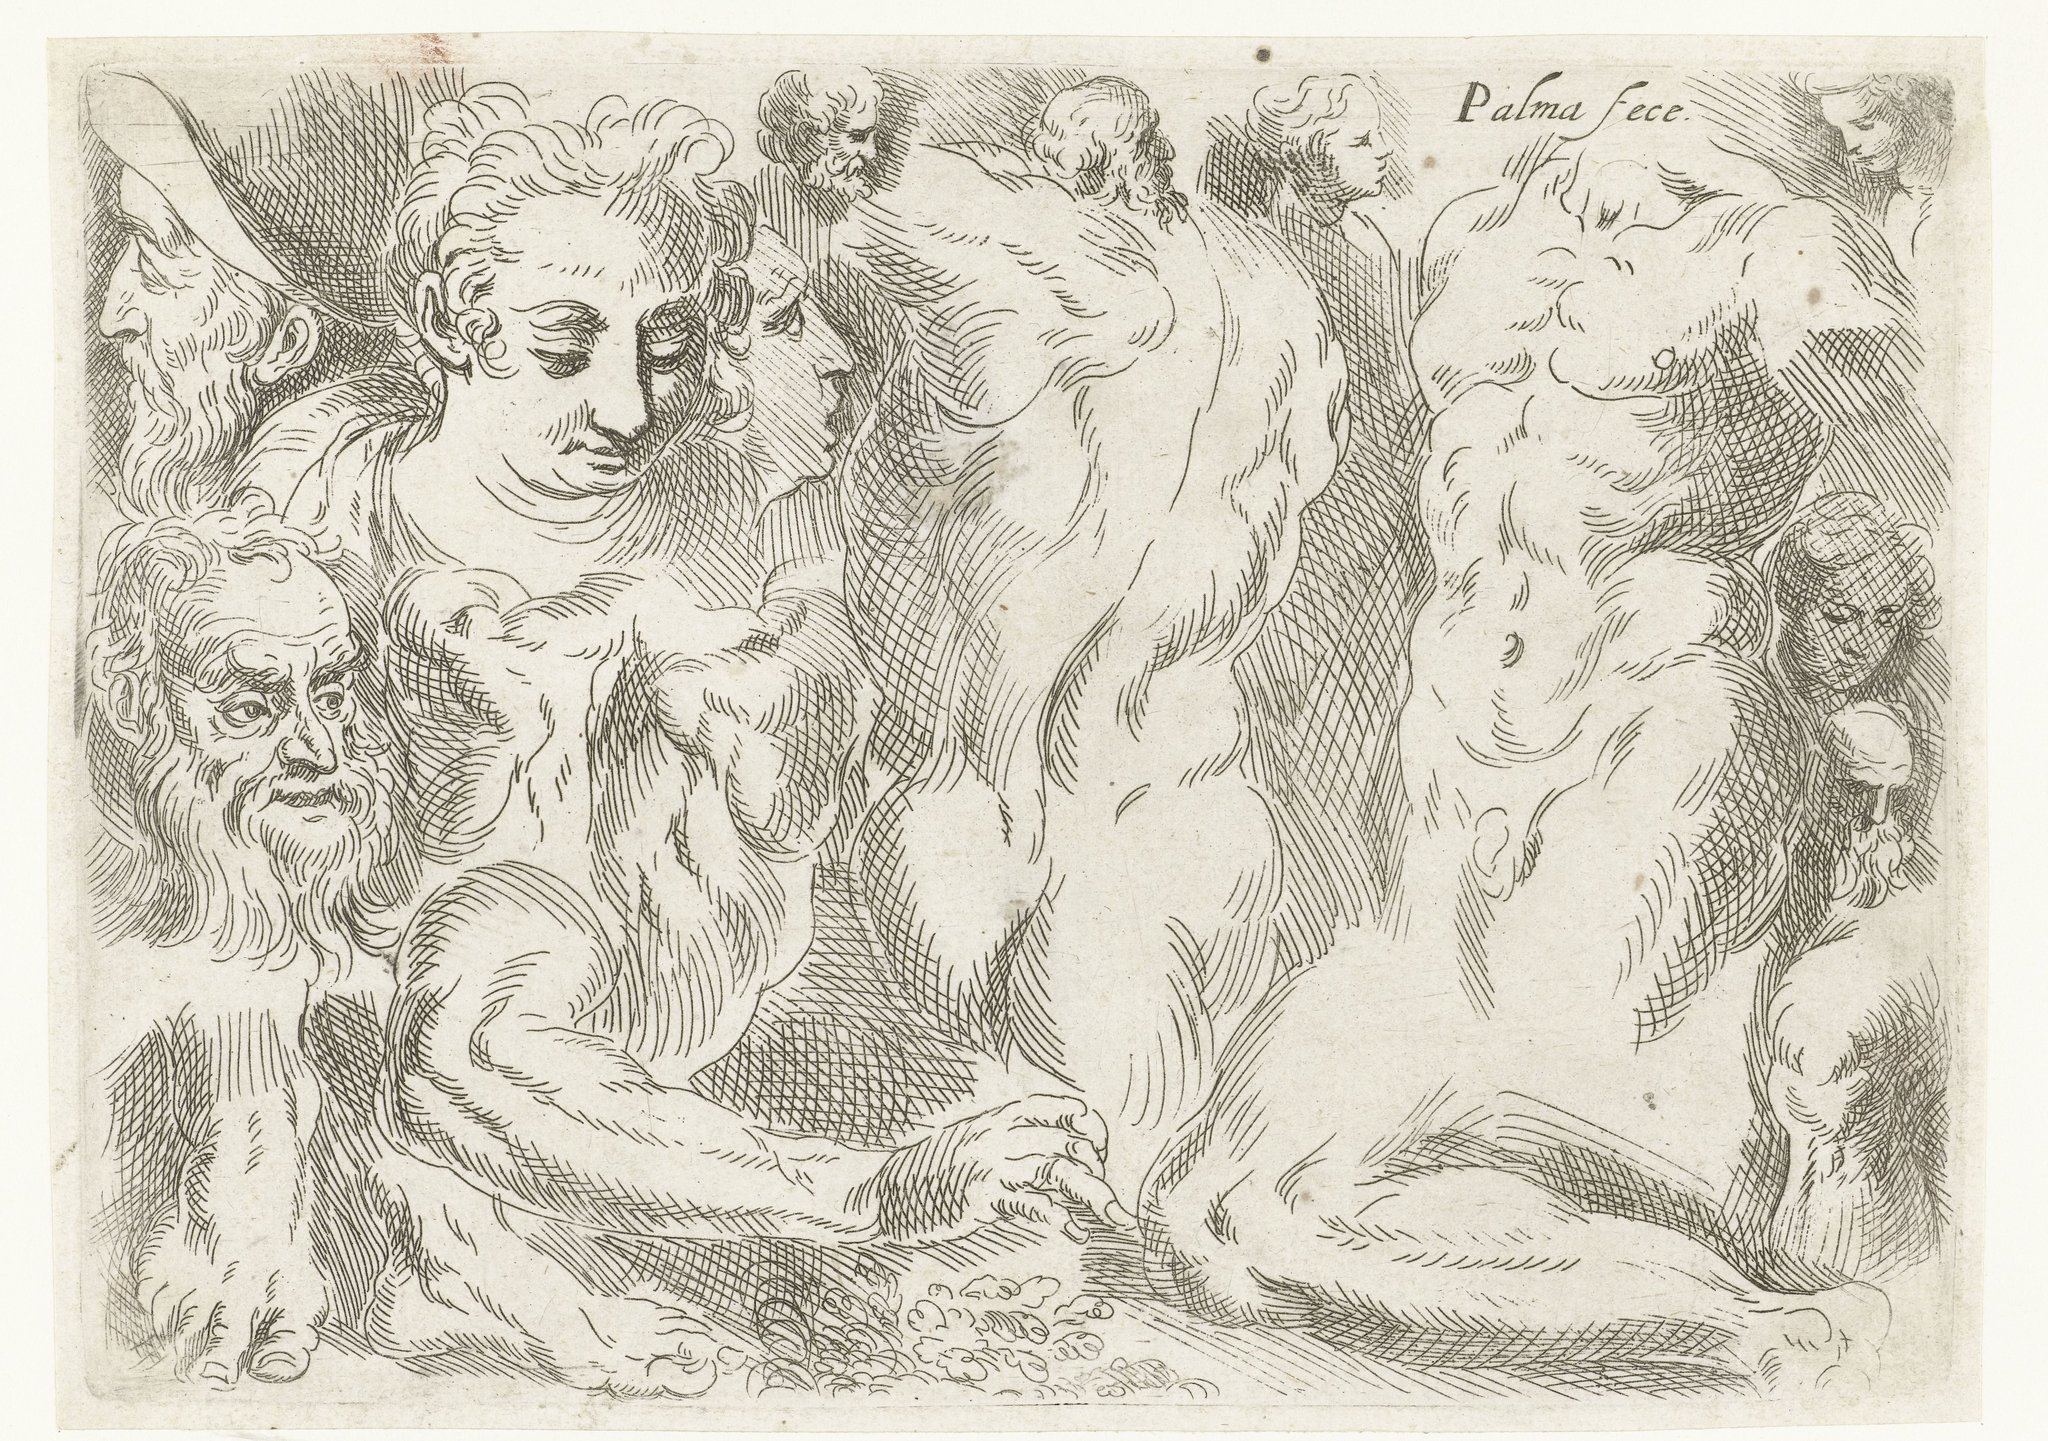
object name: print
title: Studieblad met hoofden, torso's, armen, benen en voeten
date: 1554-1611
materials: paper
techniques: etching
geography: italy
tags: head (human), arms, torso, foot, legs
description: Een studieblad uit een handboek voor de tekenkunst, met hoofden, torso's, armen, benen en voeten in verschillende vormen en houdingen.